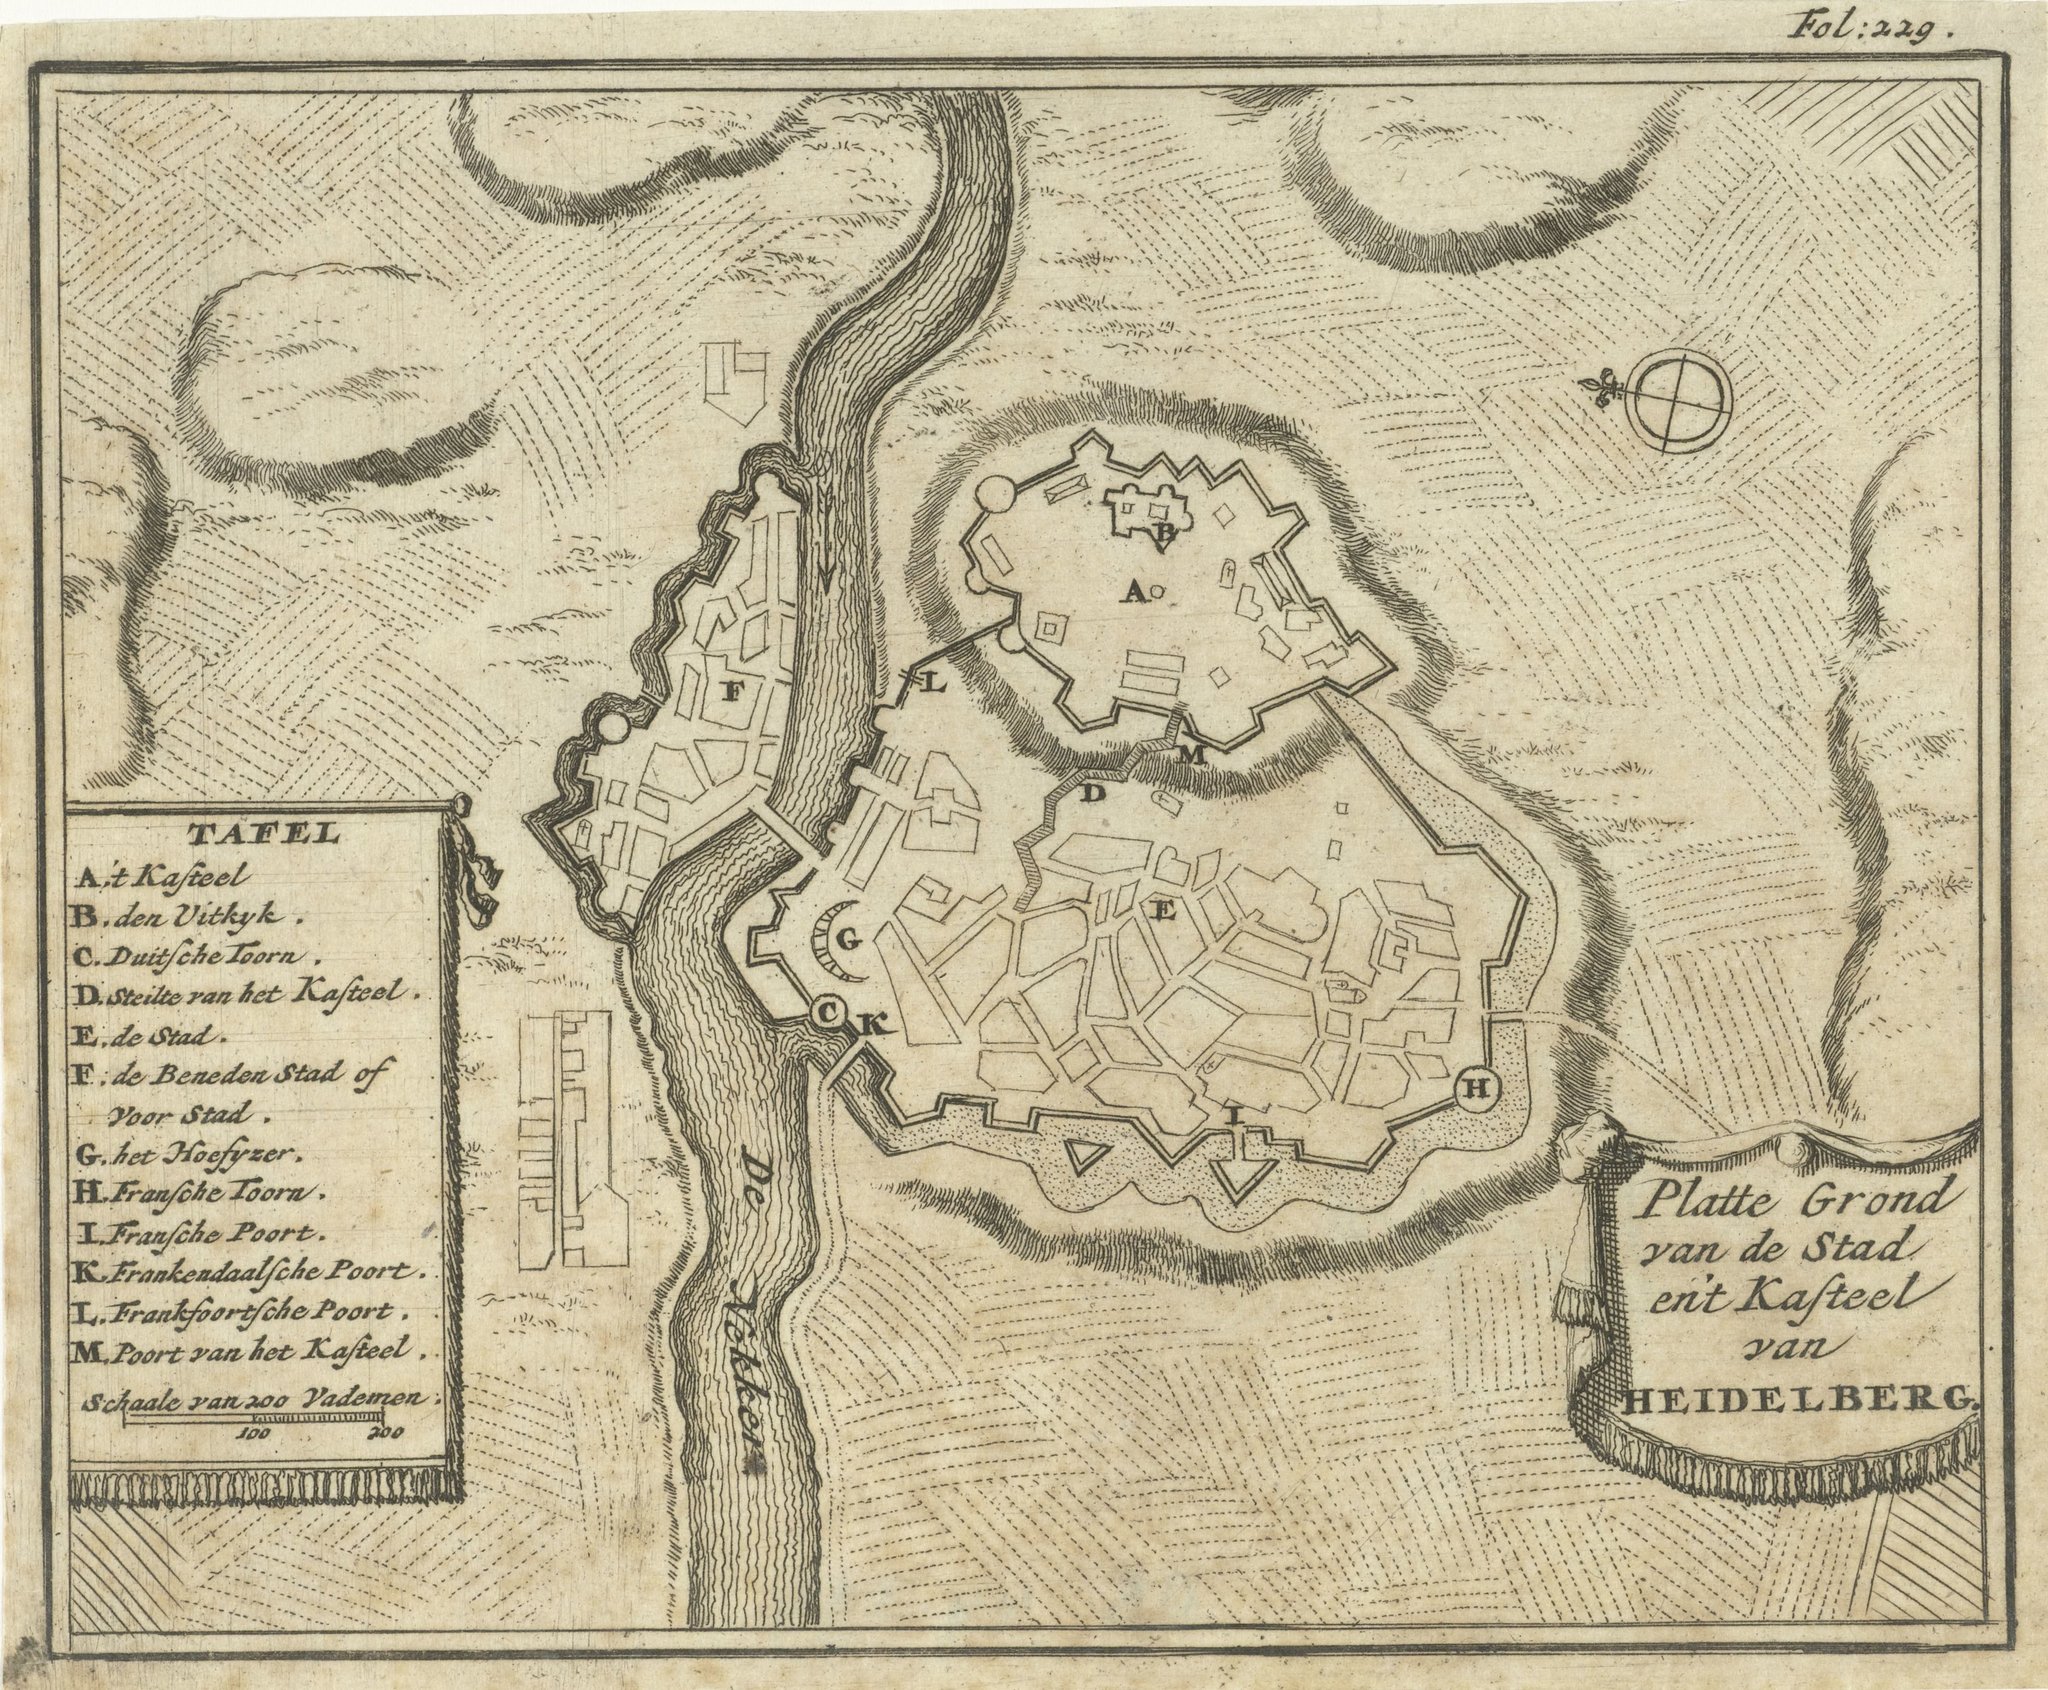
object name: book illustration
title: Plattegrond van Heidelberg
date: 1693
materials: paper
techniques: etching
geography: amsterdam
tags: maps of cities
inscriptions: collector's mark: Lugt 2228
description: Illustratie uit: Europische Mercurius, behelzende al het voornaamste 'tgeen, zo omtrent de zaaken van staat als oorlog (...) is voorgevallen (...). Vierde Stuk, begrypende (...) het jaar 1693. Amsterdam: Timotheus ten Hoorn, 1693, dl. I.